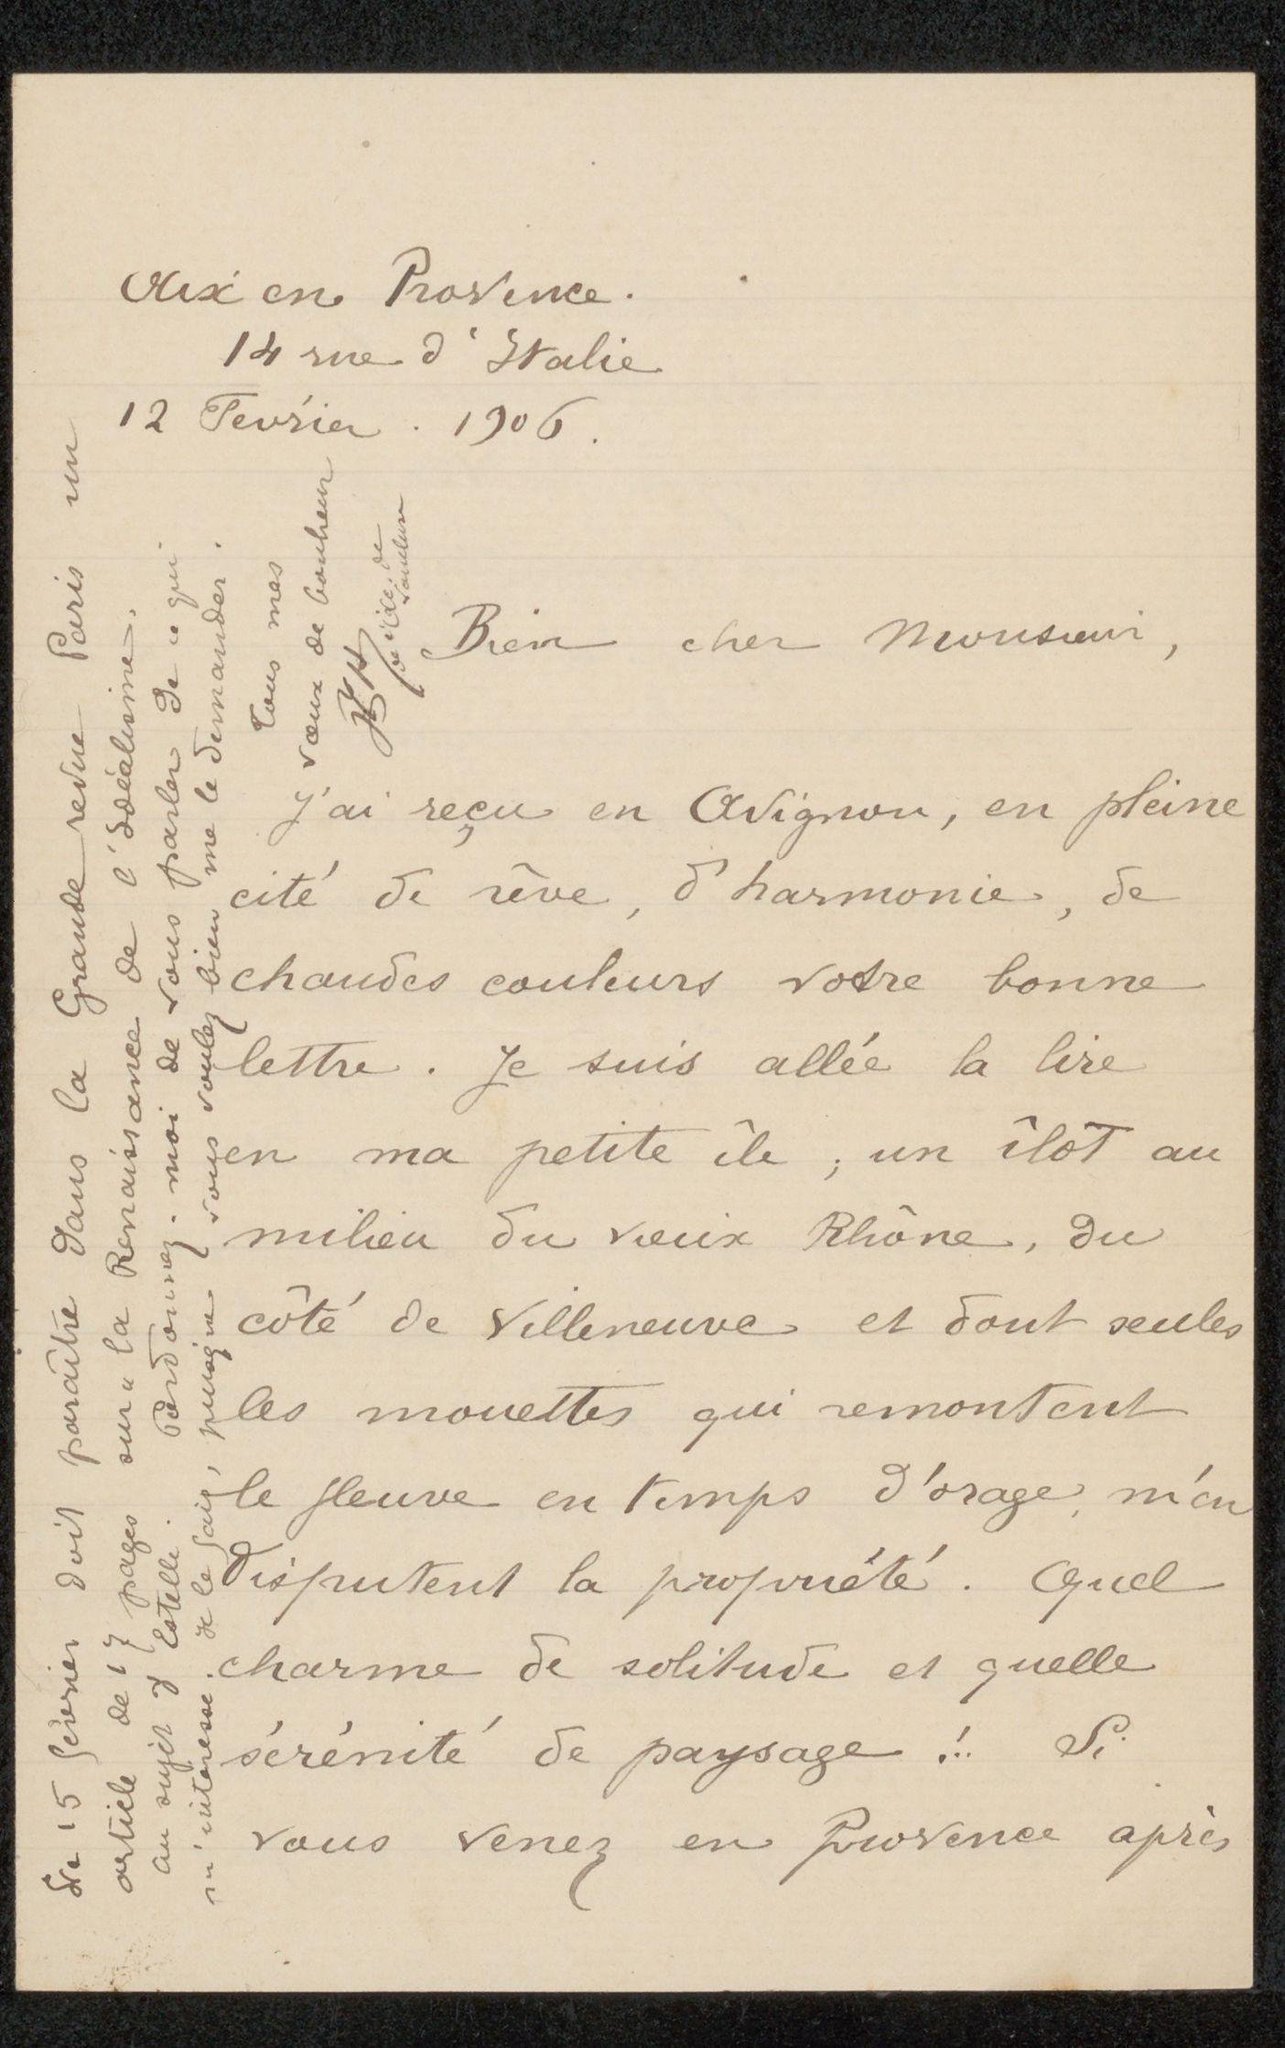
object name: letter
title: Brief aan Philip Zilcken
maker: eugénie clapier-houchart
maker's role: dichter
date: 1906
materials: ink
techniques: pen, writing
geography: aix-en-provence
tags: painter, draughtsman, philip zilcken, literature ~ arts, the graphic arts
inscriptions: collector's mark: ‘RPK’, watermark